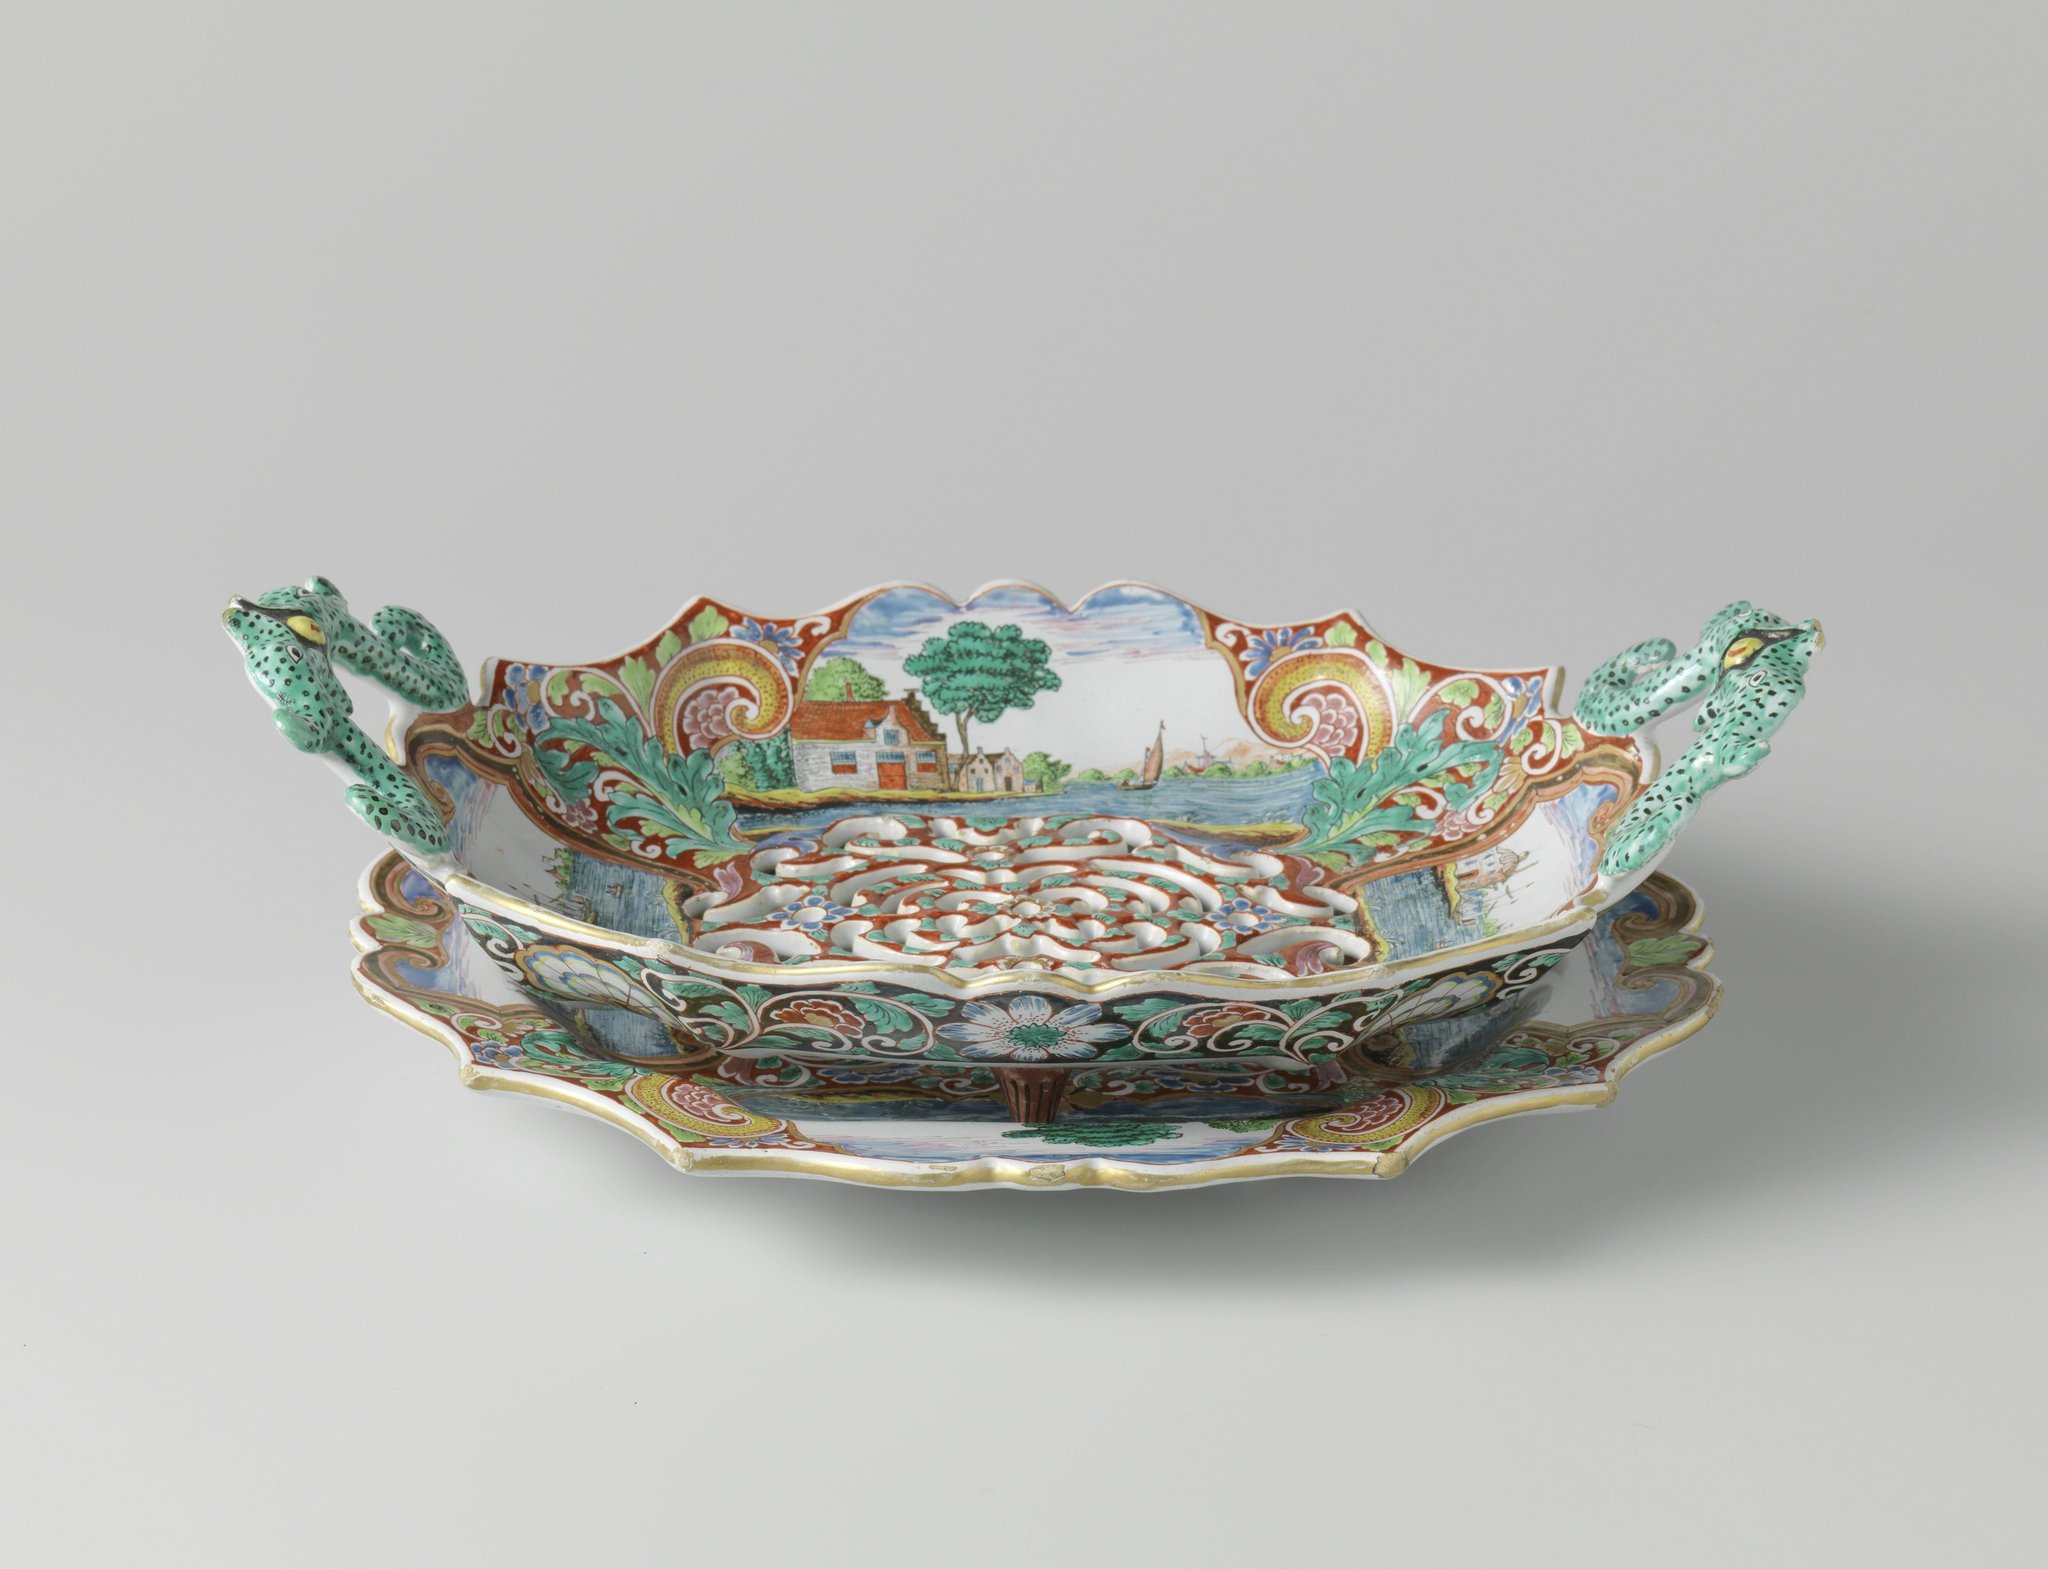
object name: vergiet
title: Onderschotel, veelkleurig beschilderd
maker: Anonymous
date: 1760-1790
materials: faience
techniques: kiln, painted, polychromy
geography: delft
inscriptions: collector's mark: ‘collection J.F. Loudon’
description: De onderschotel heeft een ovale vorm veelkleurig beschilderd met waterlandschapjes in cartouches.